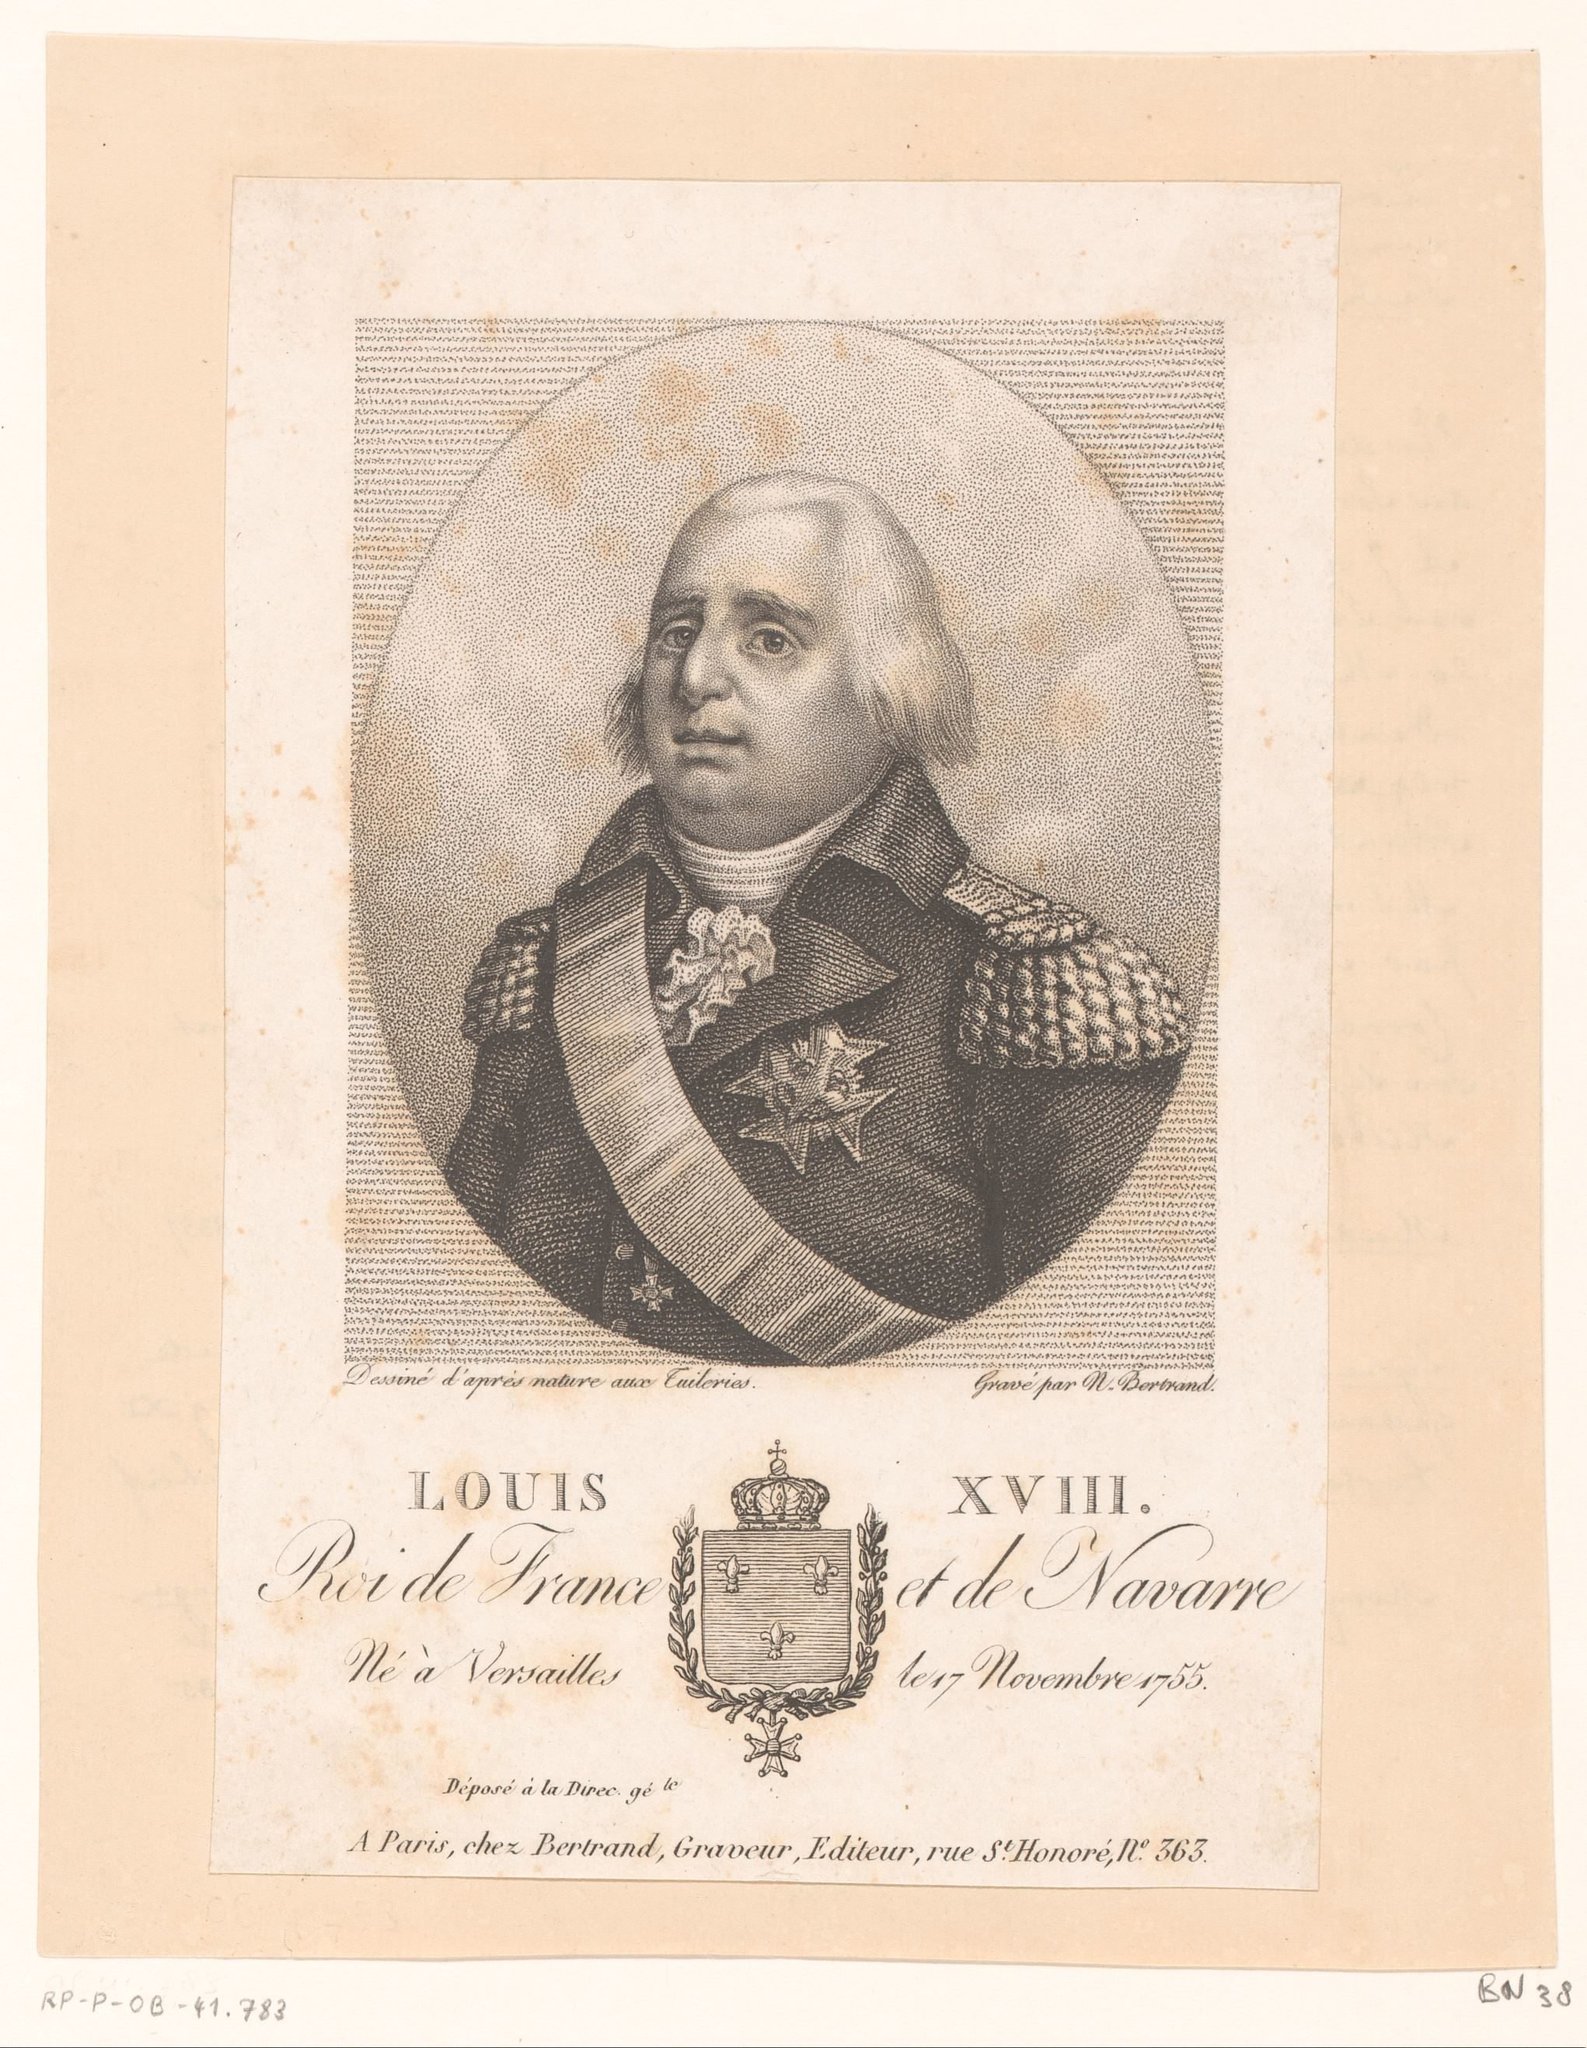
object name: print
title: Portret van Lodewijk XVIII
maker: noël françois bertrand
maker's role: print maker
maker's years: 1785-1852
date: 1795-1852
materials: paper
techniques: etching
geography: paris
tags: paris, lodewijk xviii (koning van frankrijk), historical persons, armorial bearing, heraldry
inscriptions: inscription: ‘Louis (...) XVIII Broeder van (...)’